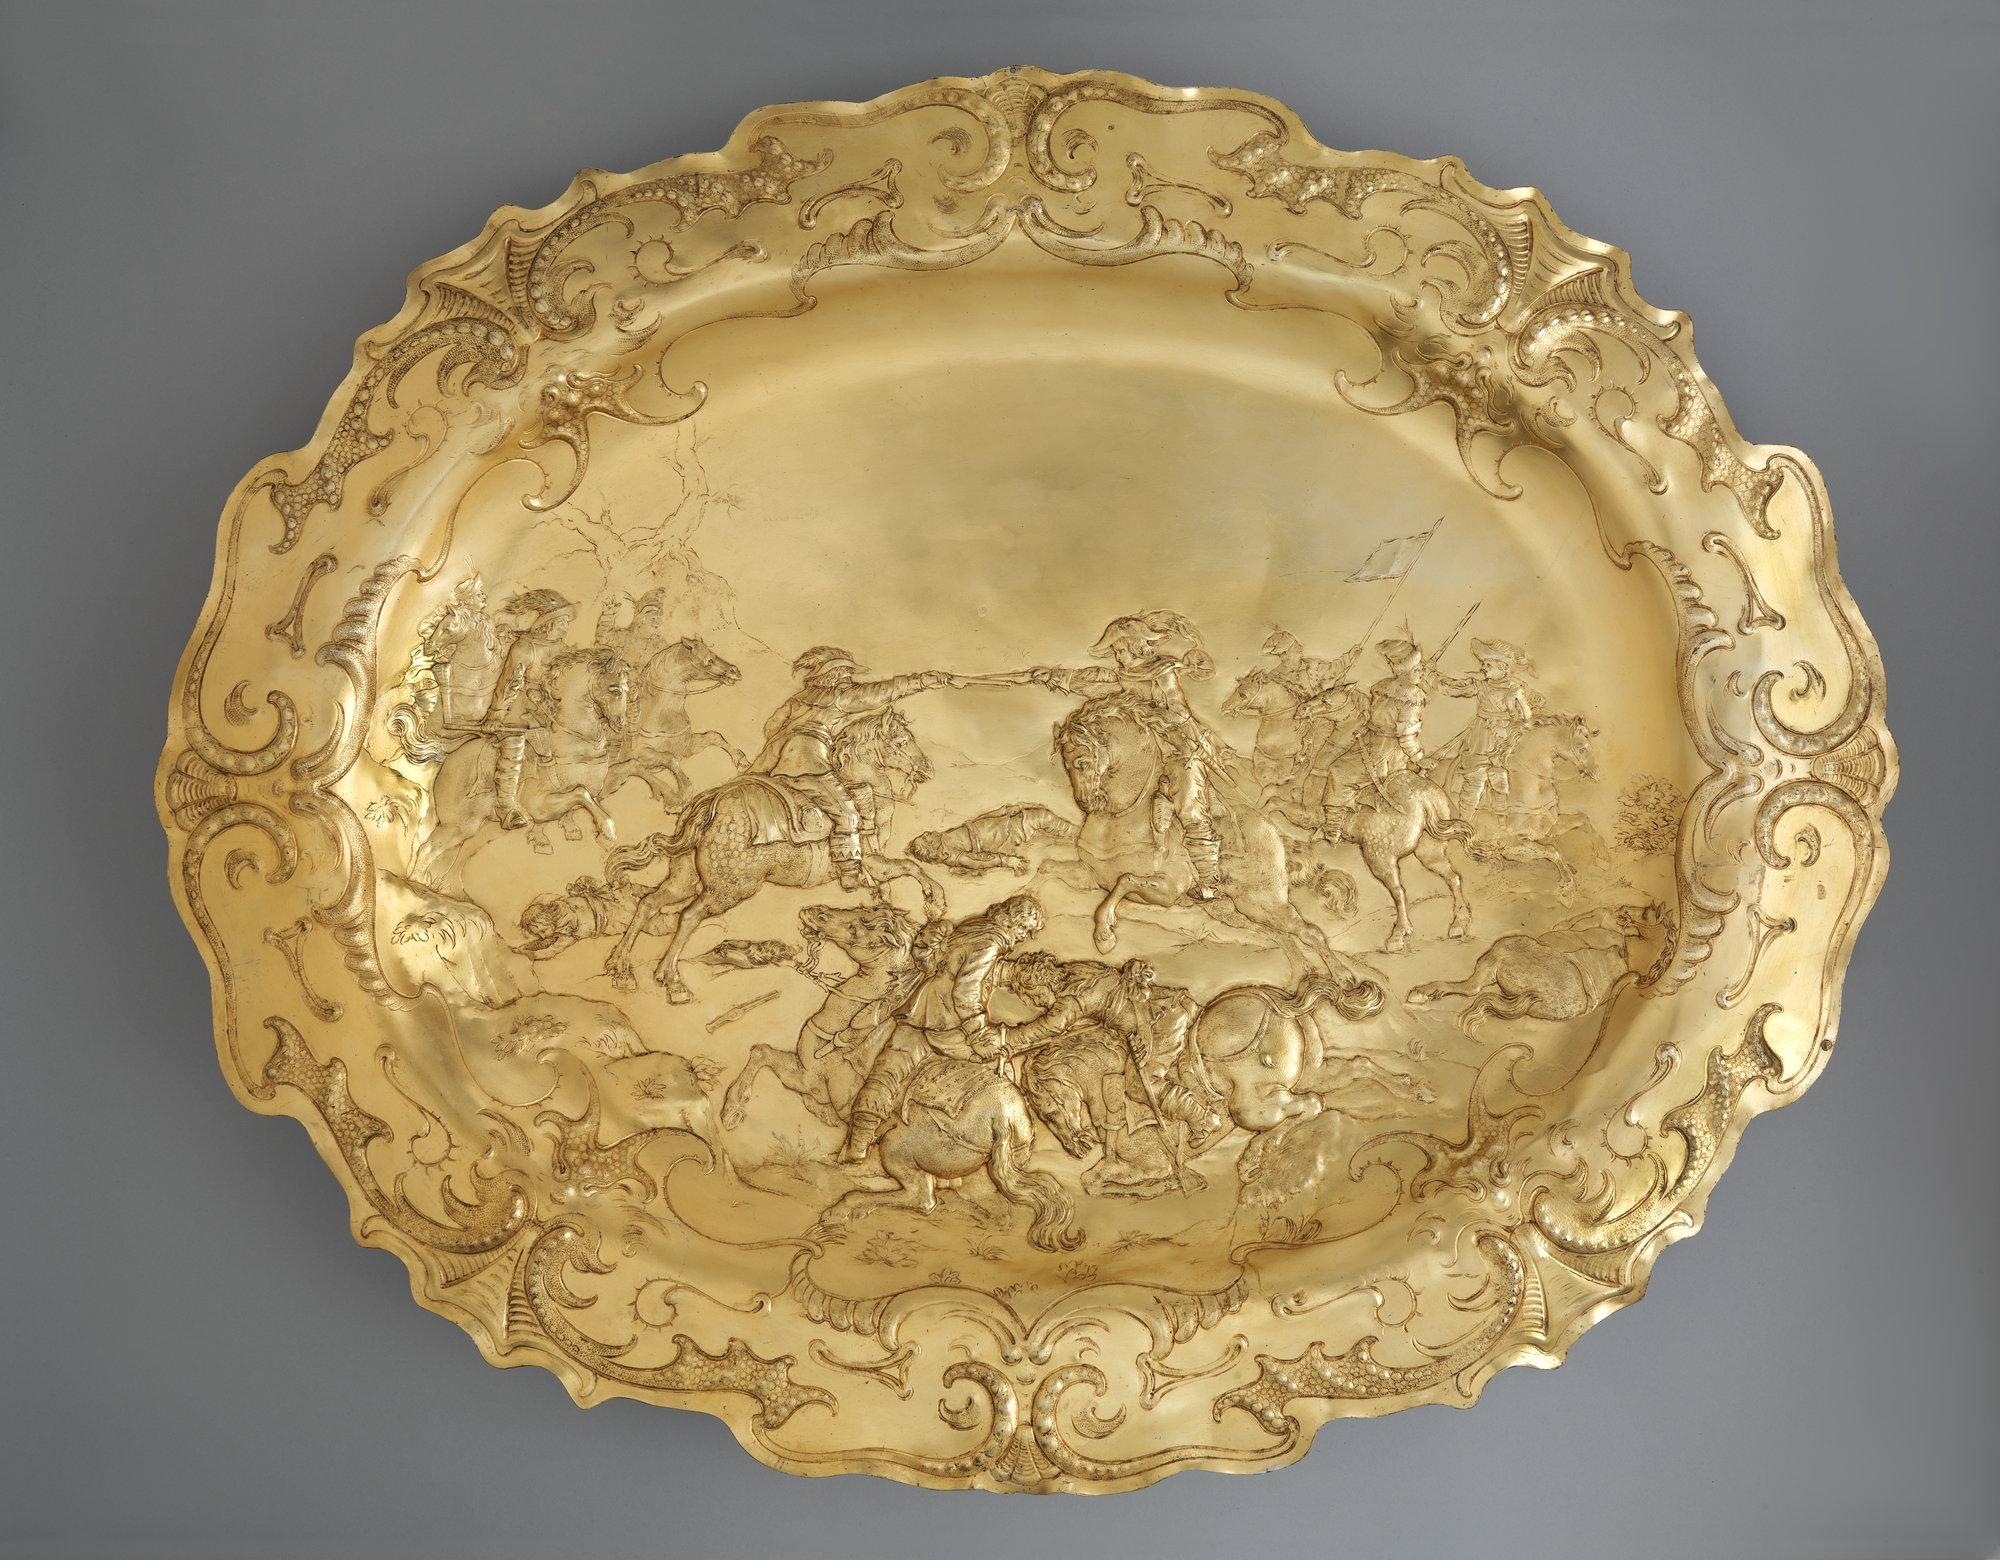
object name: plateau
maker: elkington & co.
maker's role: manufacturer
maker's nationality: british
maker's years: 1829-1963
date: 1801-1900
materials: copper, gilt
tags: human figures,battles,swords,horses